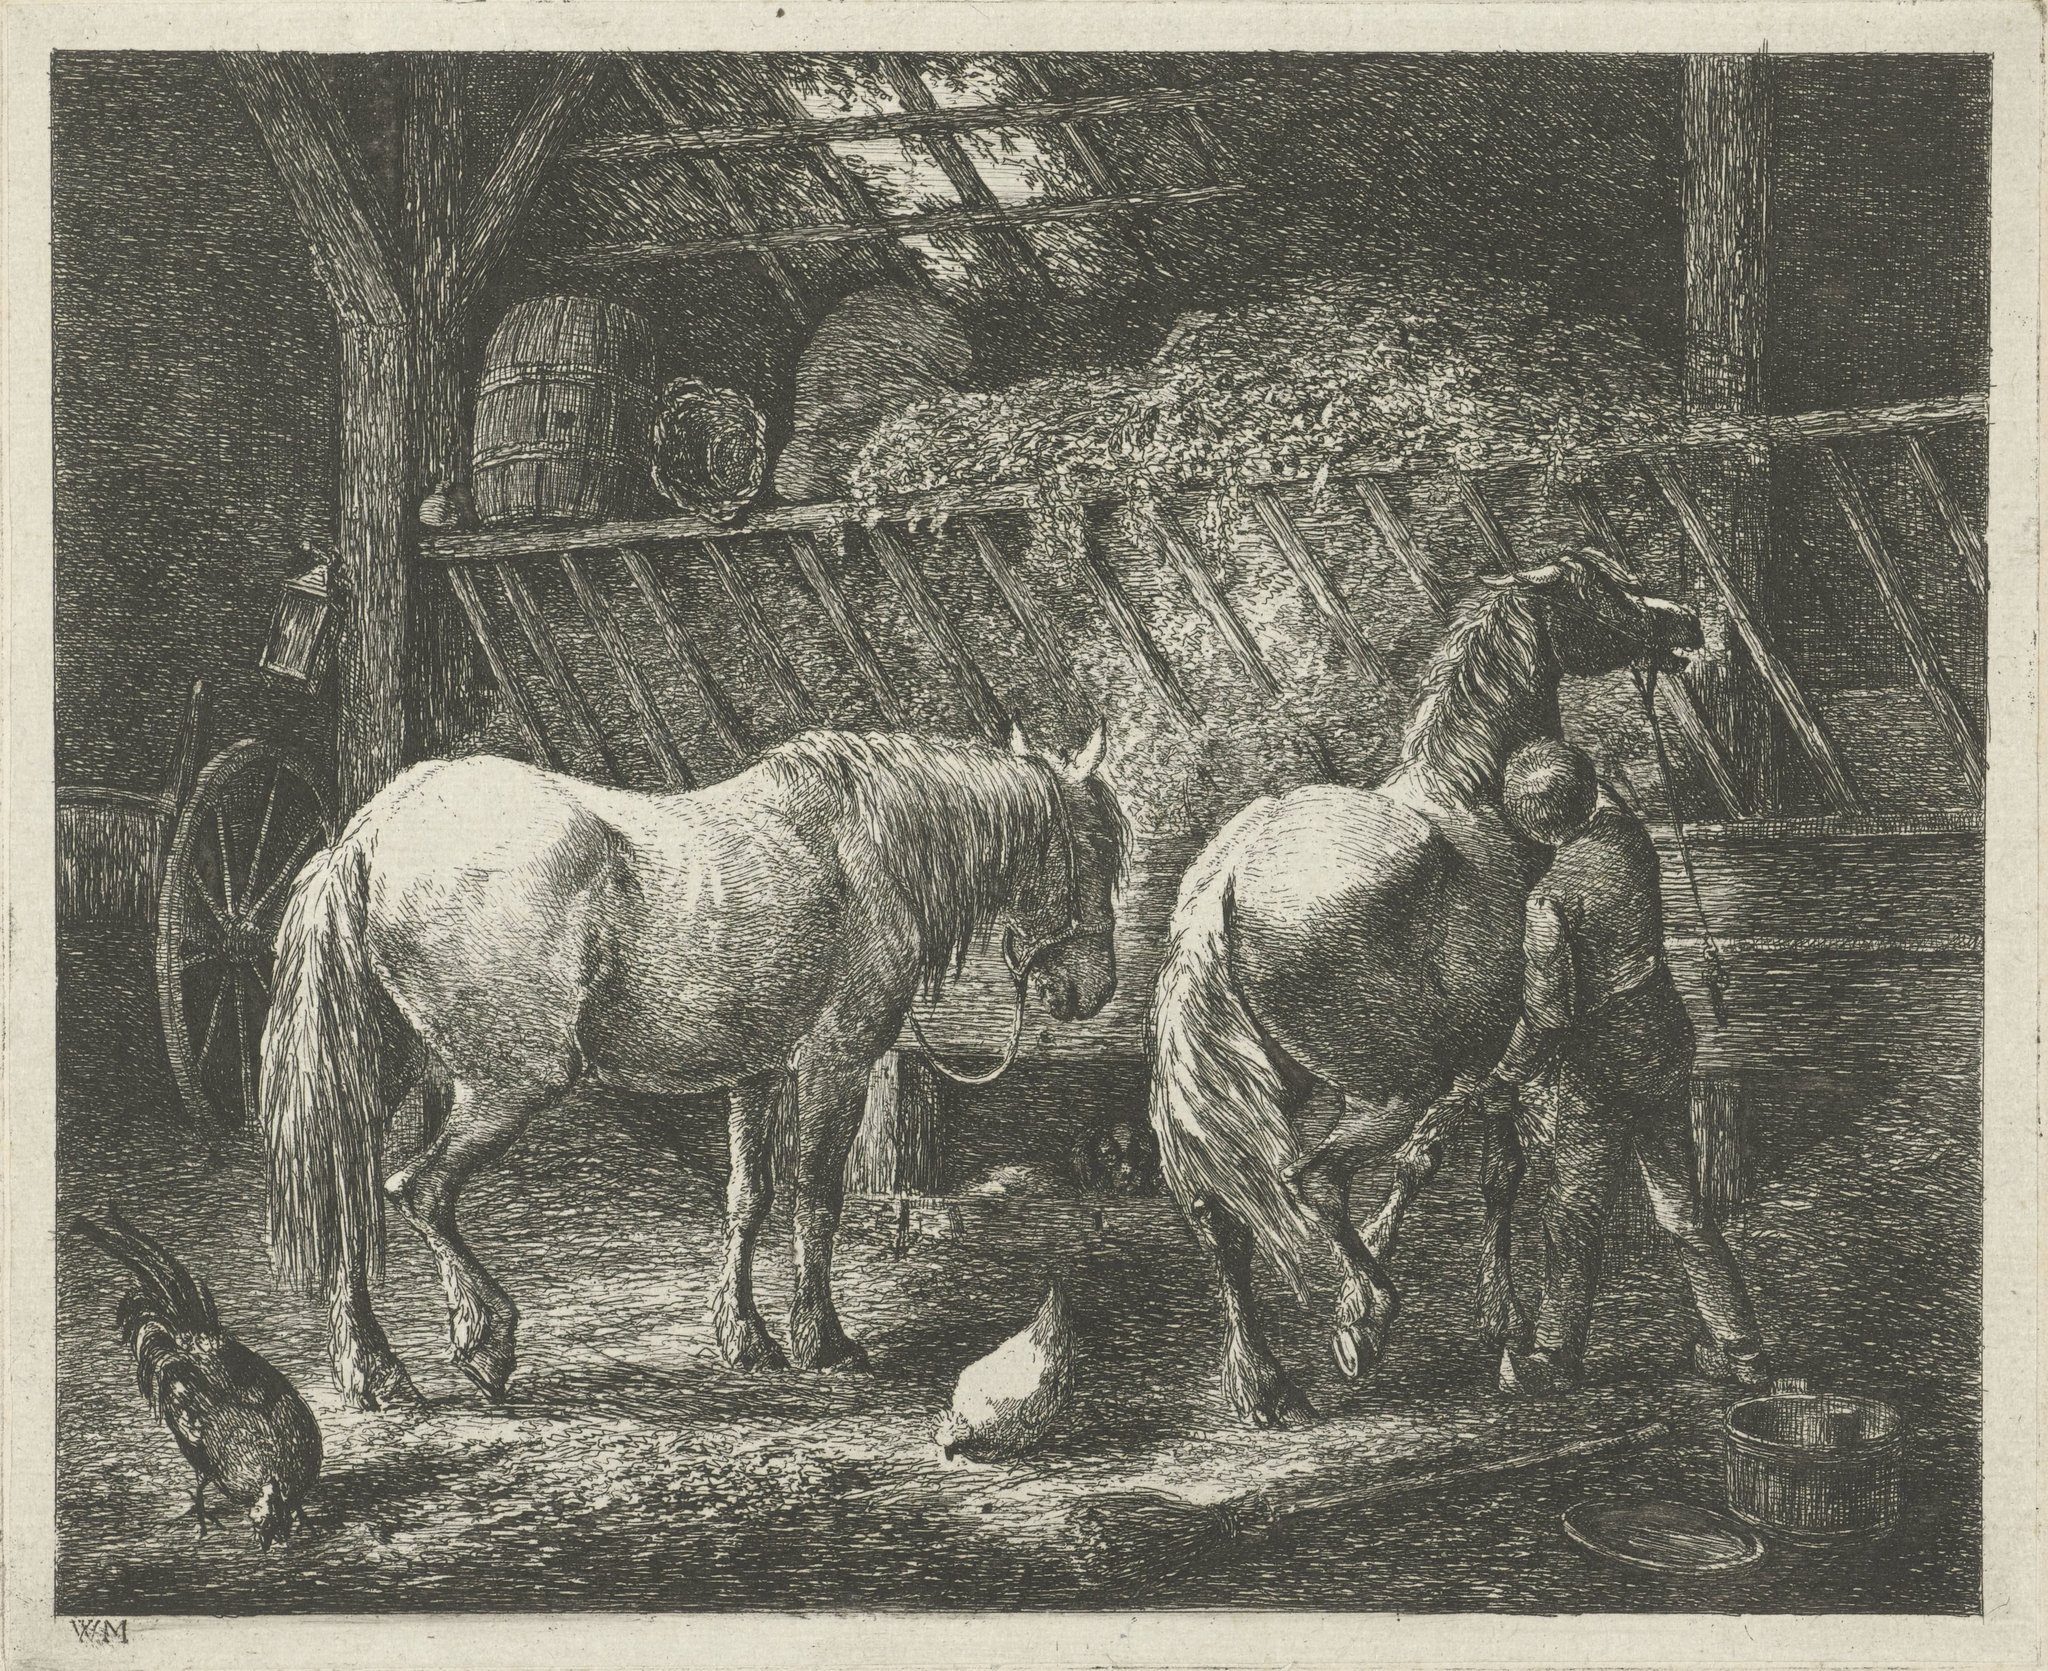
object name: print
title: Stalinterieur met twee paarden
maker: christiaan wilhelmus moorrees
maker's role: draughtsman, print maker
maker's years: 1801-1867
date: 1811-1867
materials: paper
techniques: etching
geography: amsterdam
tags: horse, stall, stable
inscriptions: collector's mark: Lugt 2228, collector's mark: Lugt 2760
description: Twee paarden en een stalknecht in een stal voor met hooi gevulde ruiven.